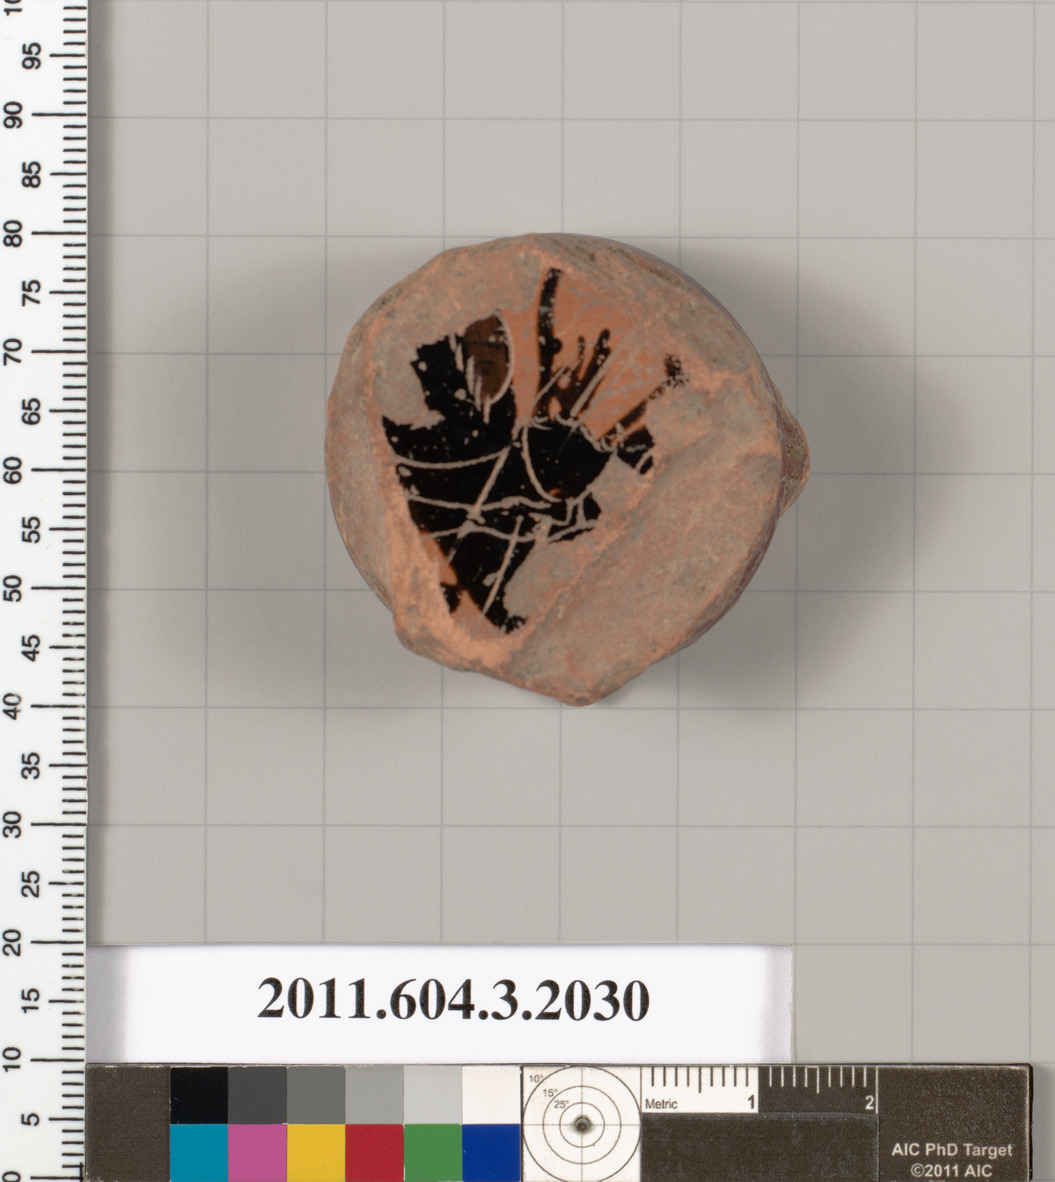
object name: kylix fragment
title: Terracotta fragment of a kylix (drinking cup)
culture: greek, attic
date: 534-468 BCE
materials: terracotta